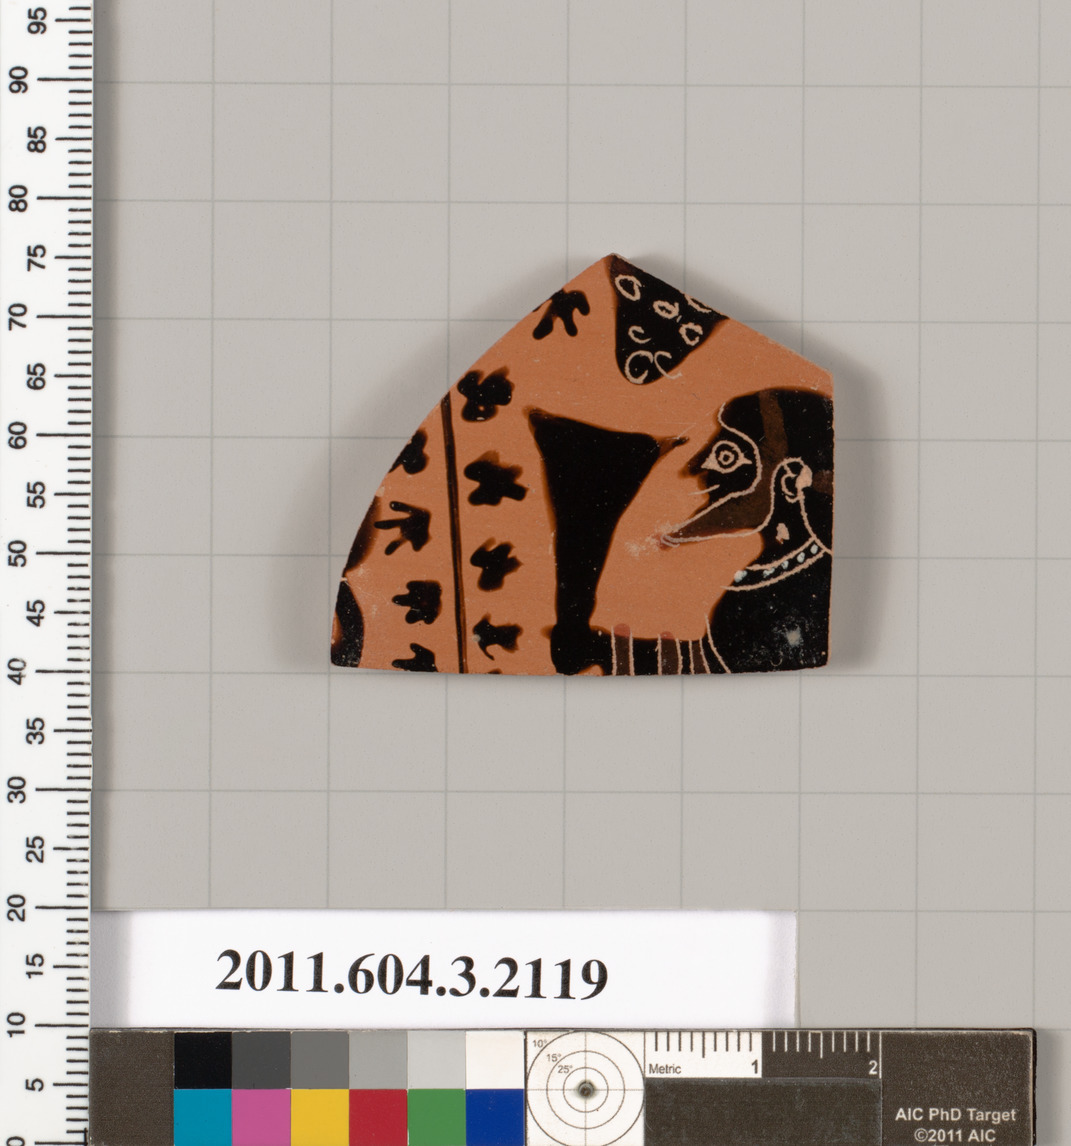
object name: kylix fragment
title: Terracotta rim fragment of a kylix (drinking cup)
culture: greek, attic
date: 550-526 BCE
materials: terracotta